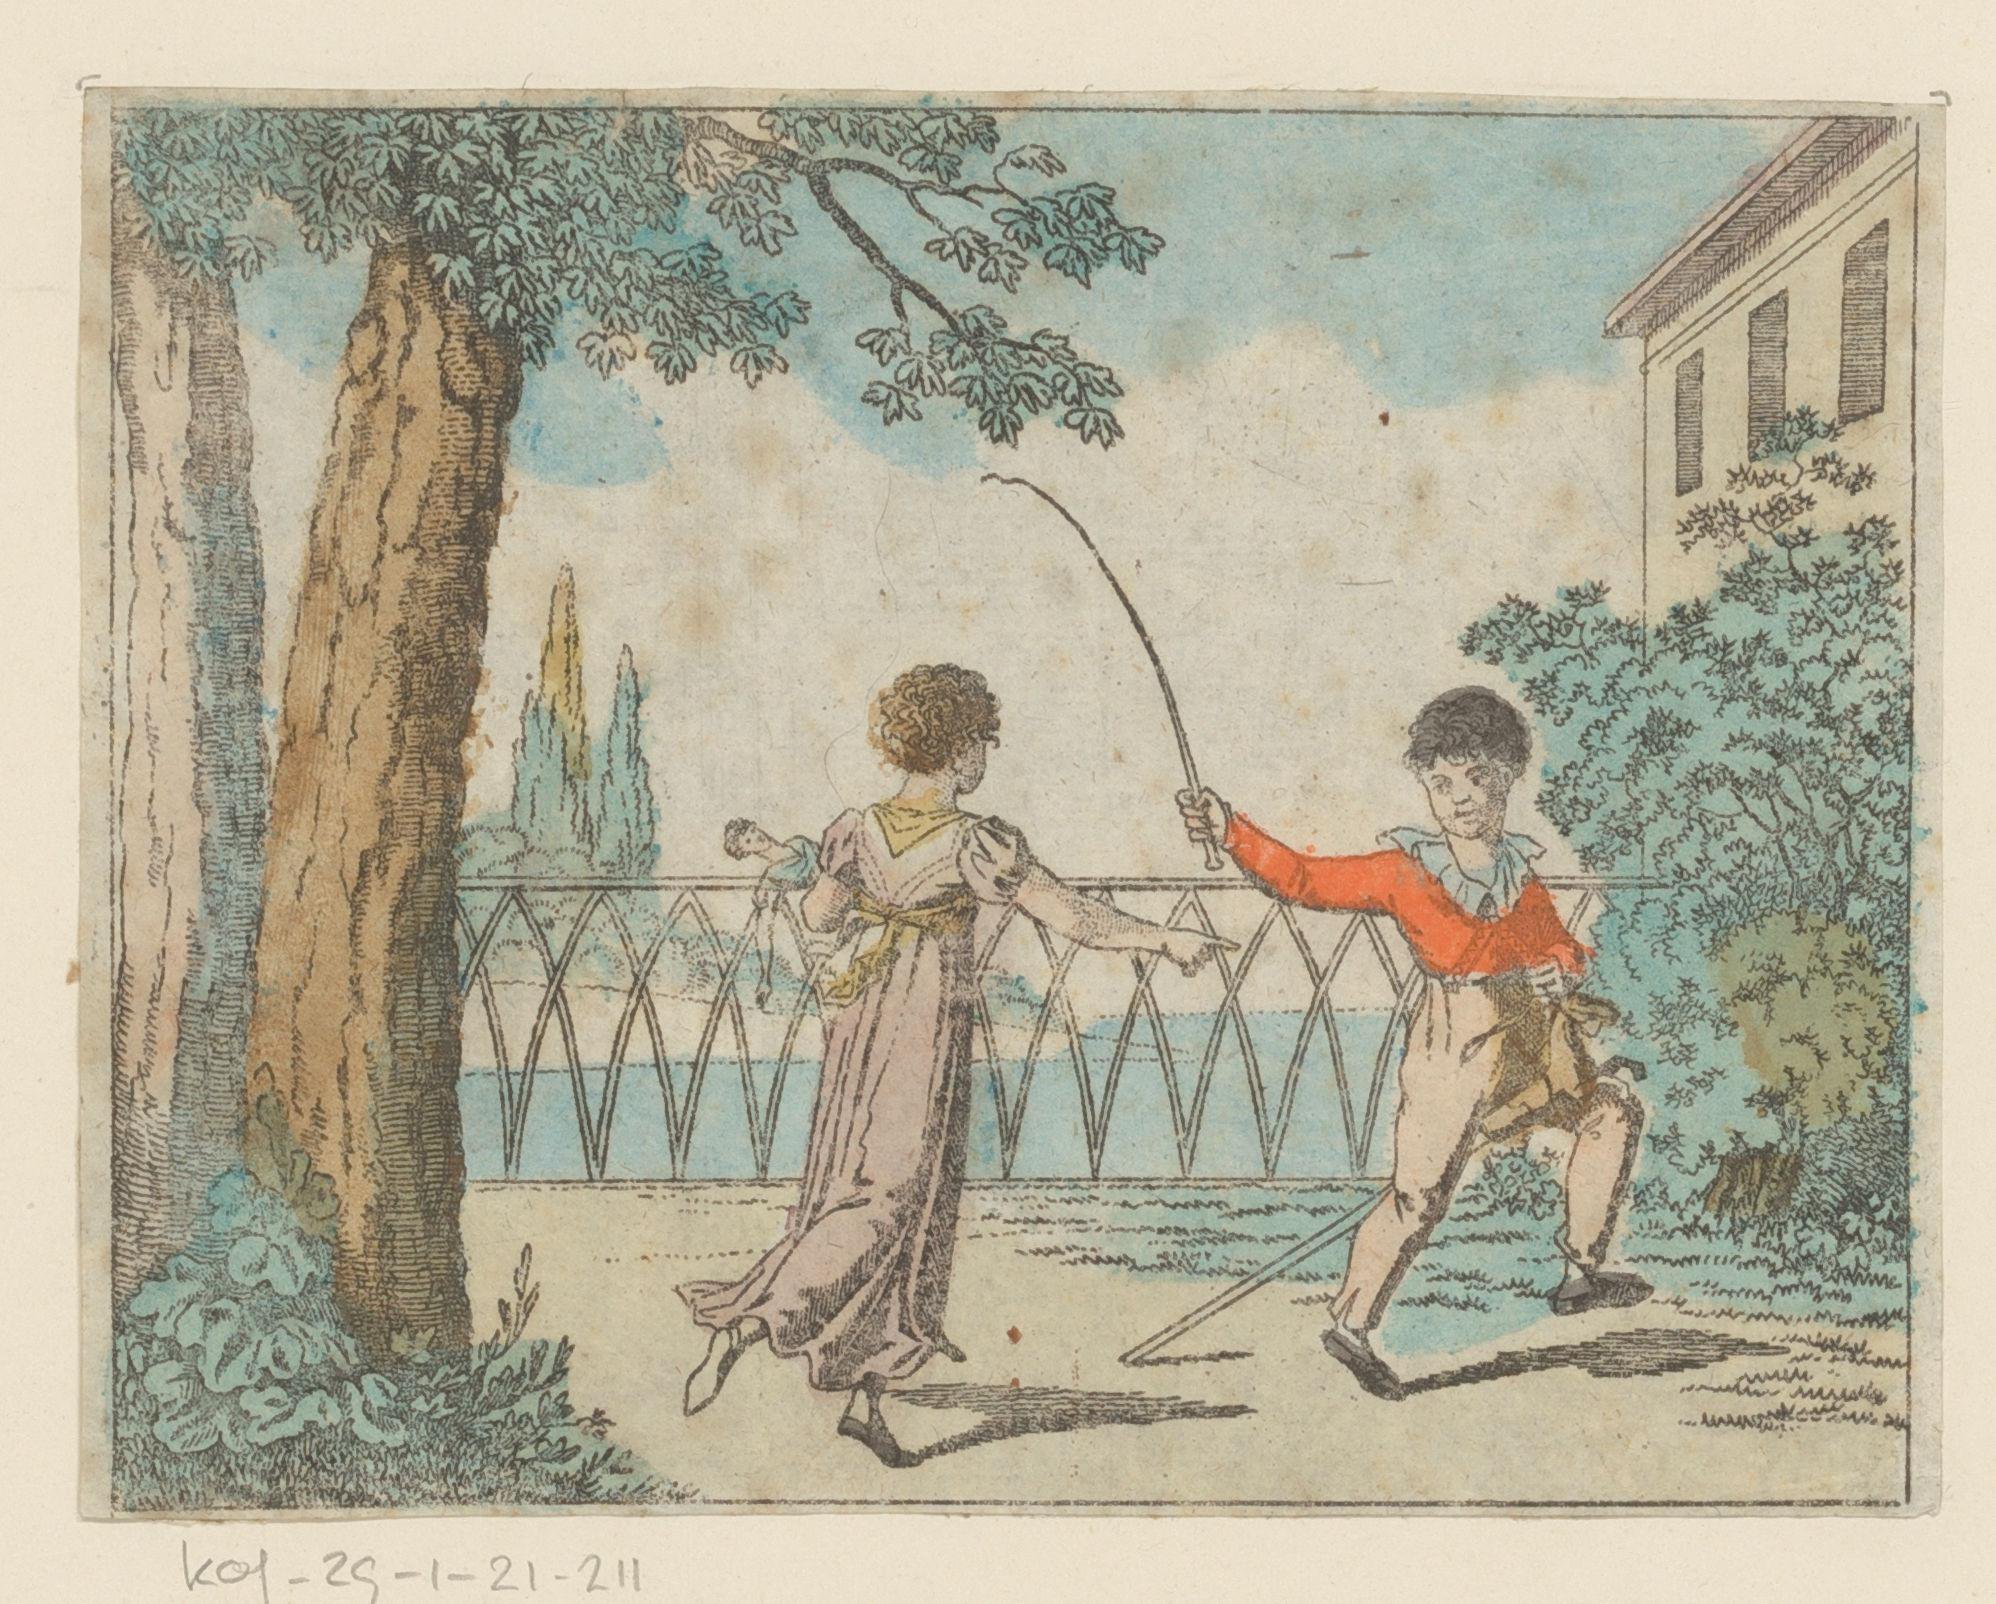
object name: print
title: Jongen speelt met een stokpaard en een meisje met een pop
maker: Anonymous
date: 1800-1849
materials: paper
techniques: hand coloring, engraving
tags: hobby-horse, children's games and plays (+ out of doors (sports, games, etc.))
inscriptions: stamp, collector's mark: Lugt 1641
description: Onderwerpsrubrieken binnen de Atlas Zeden en Gewoonten: Zeden en Gewoonten in Engeren Zin, De Kleeding, Kleederdrachten (tijdvakken), Het begin der 19de eeuw. Mannen en vrouwen.